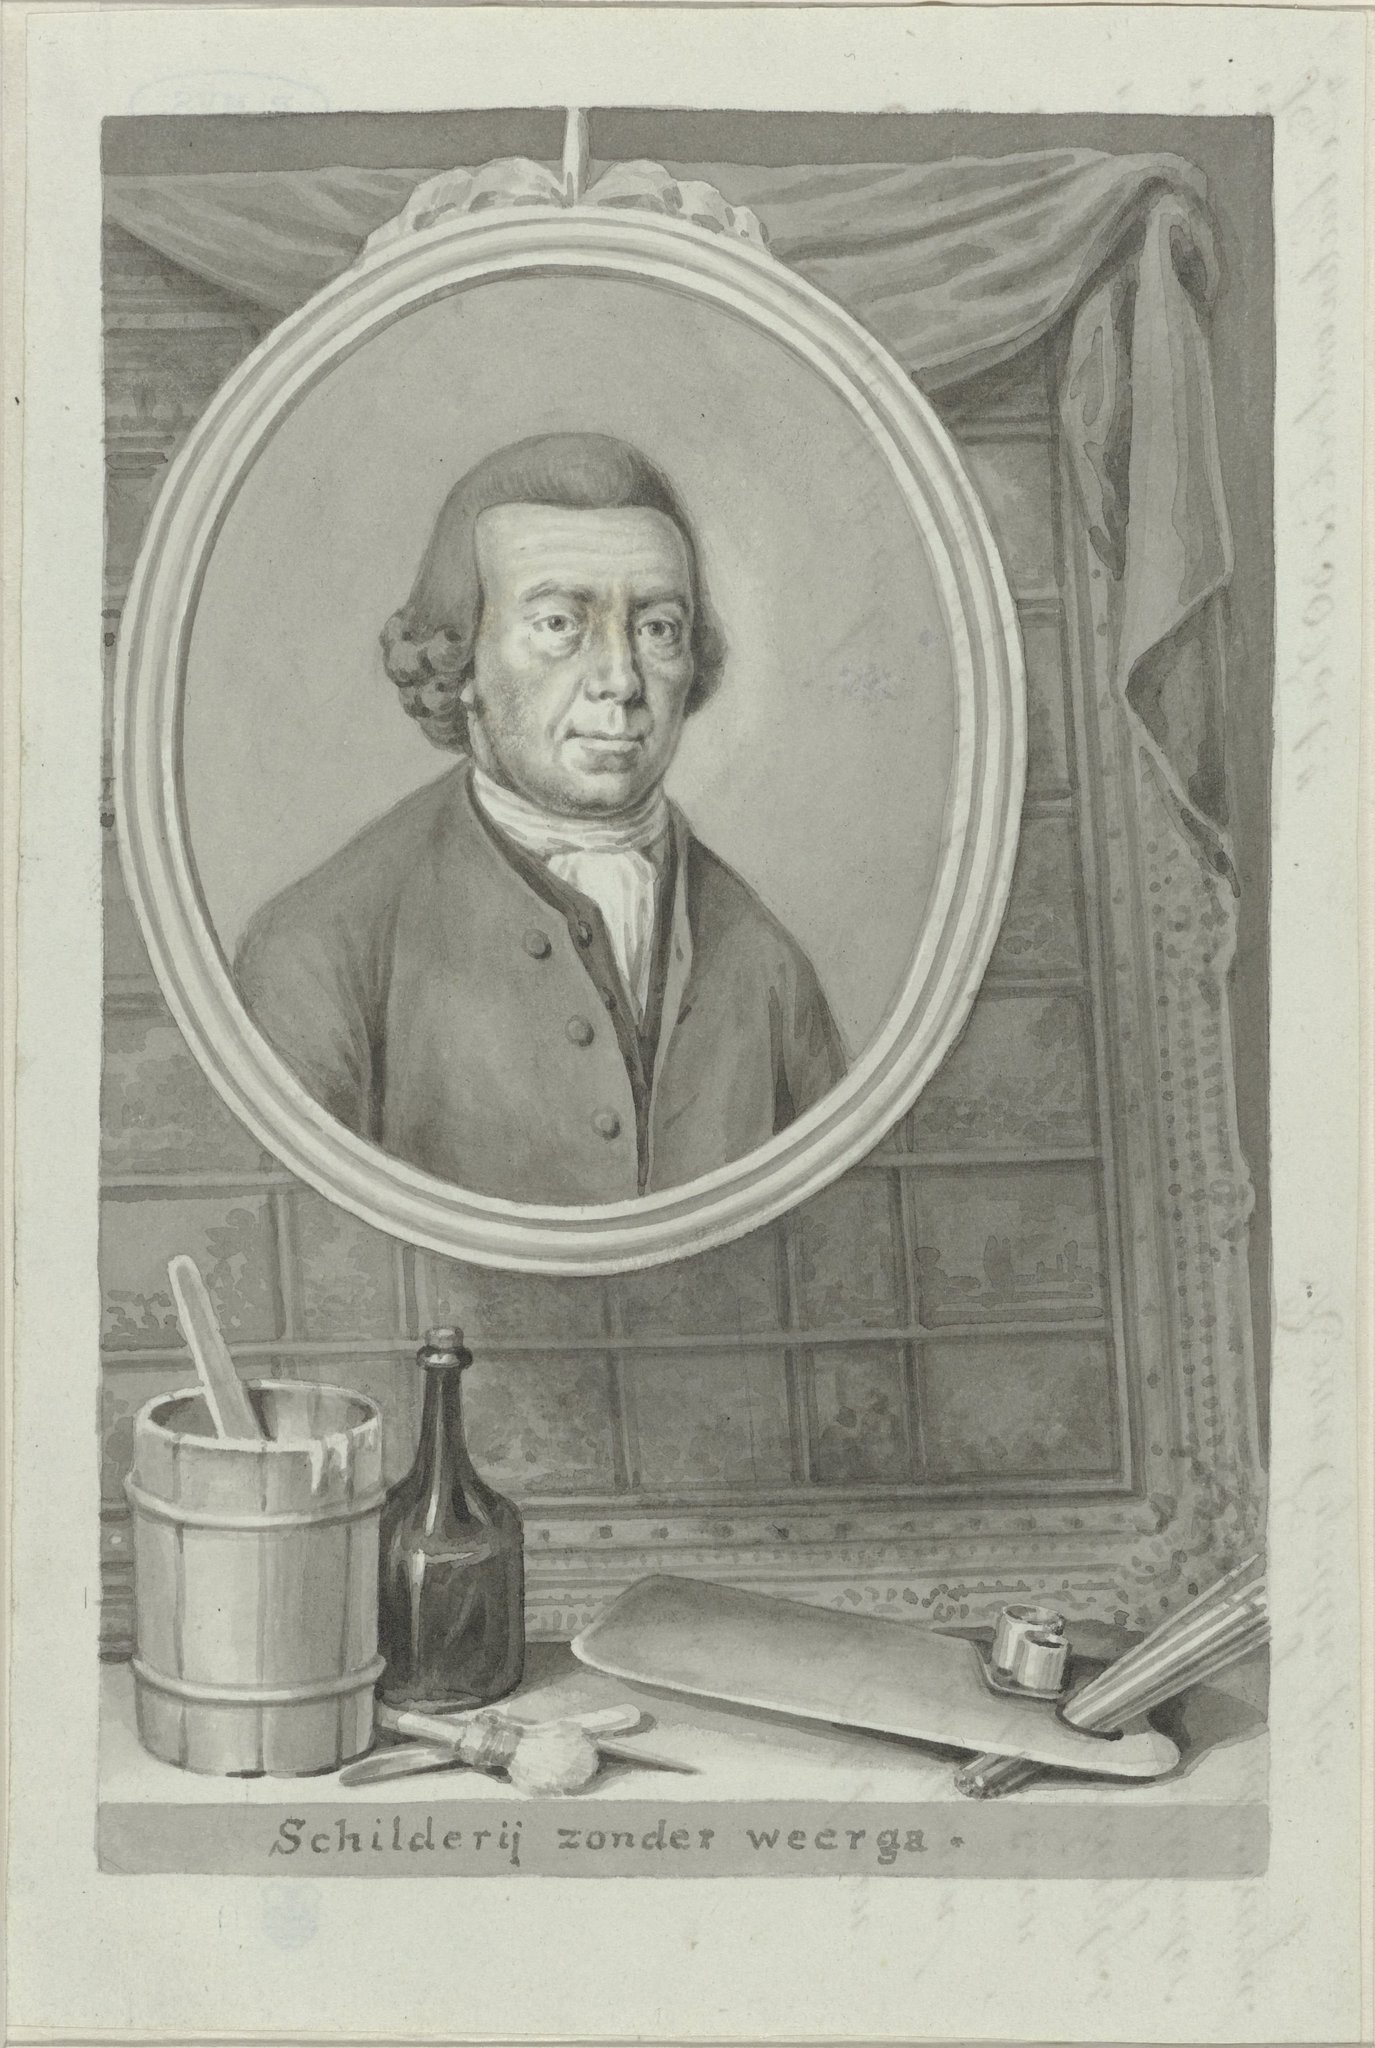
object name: drawing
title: Portret van de schilder Cornelis Vermeulen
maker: roeland van eynden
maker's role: draughtsman, print maker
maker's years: 1747-1819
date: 1757-1819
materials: paper, pencil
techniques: brush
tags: dordrecht, painter, historical persons, portrait, self-portrait of painter, portrait, self-portrait of artist